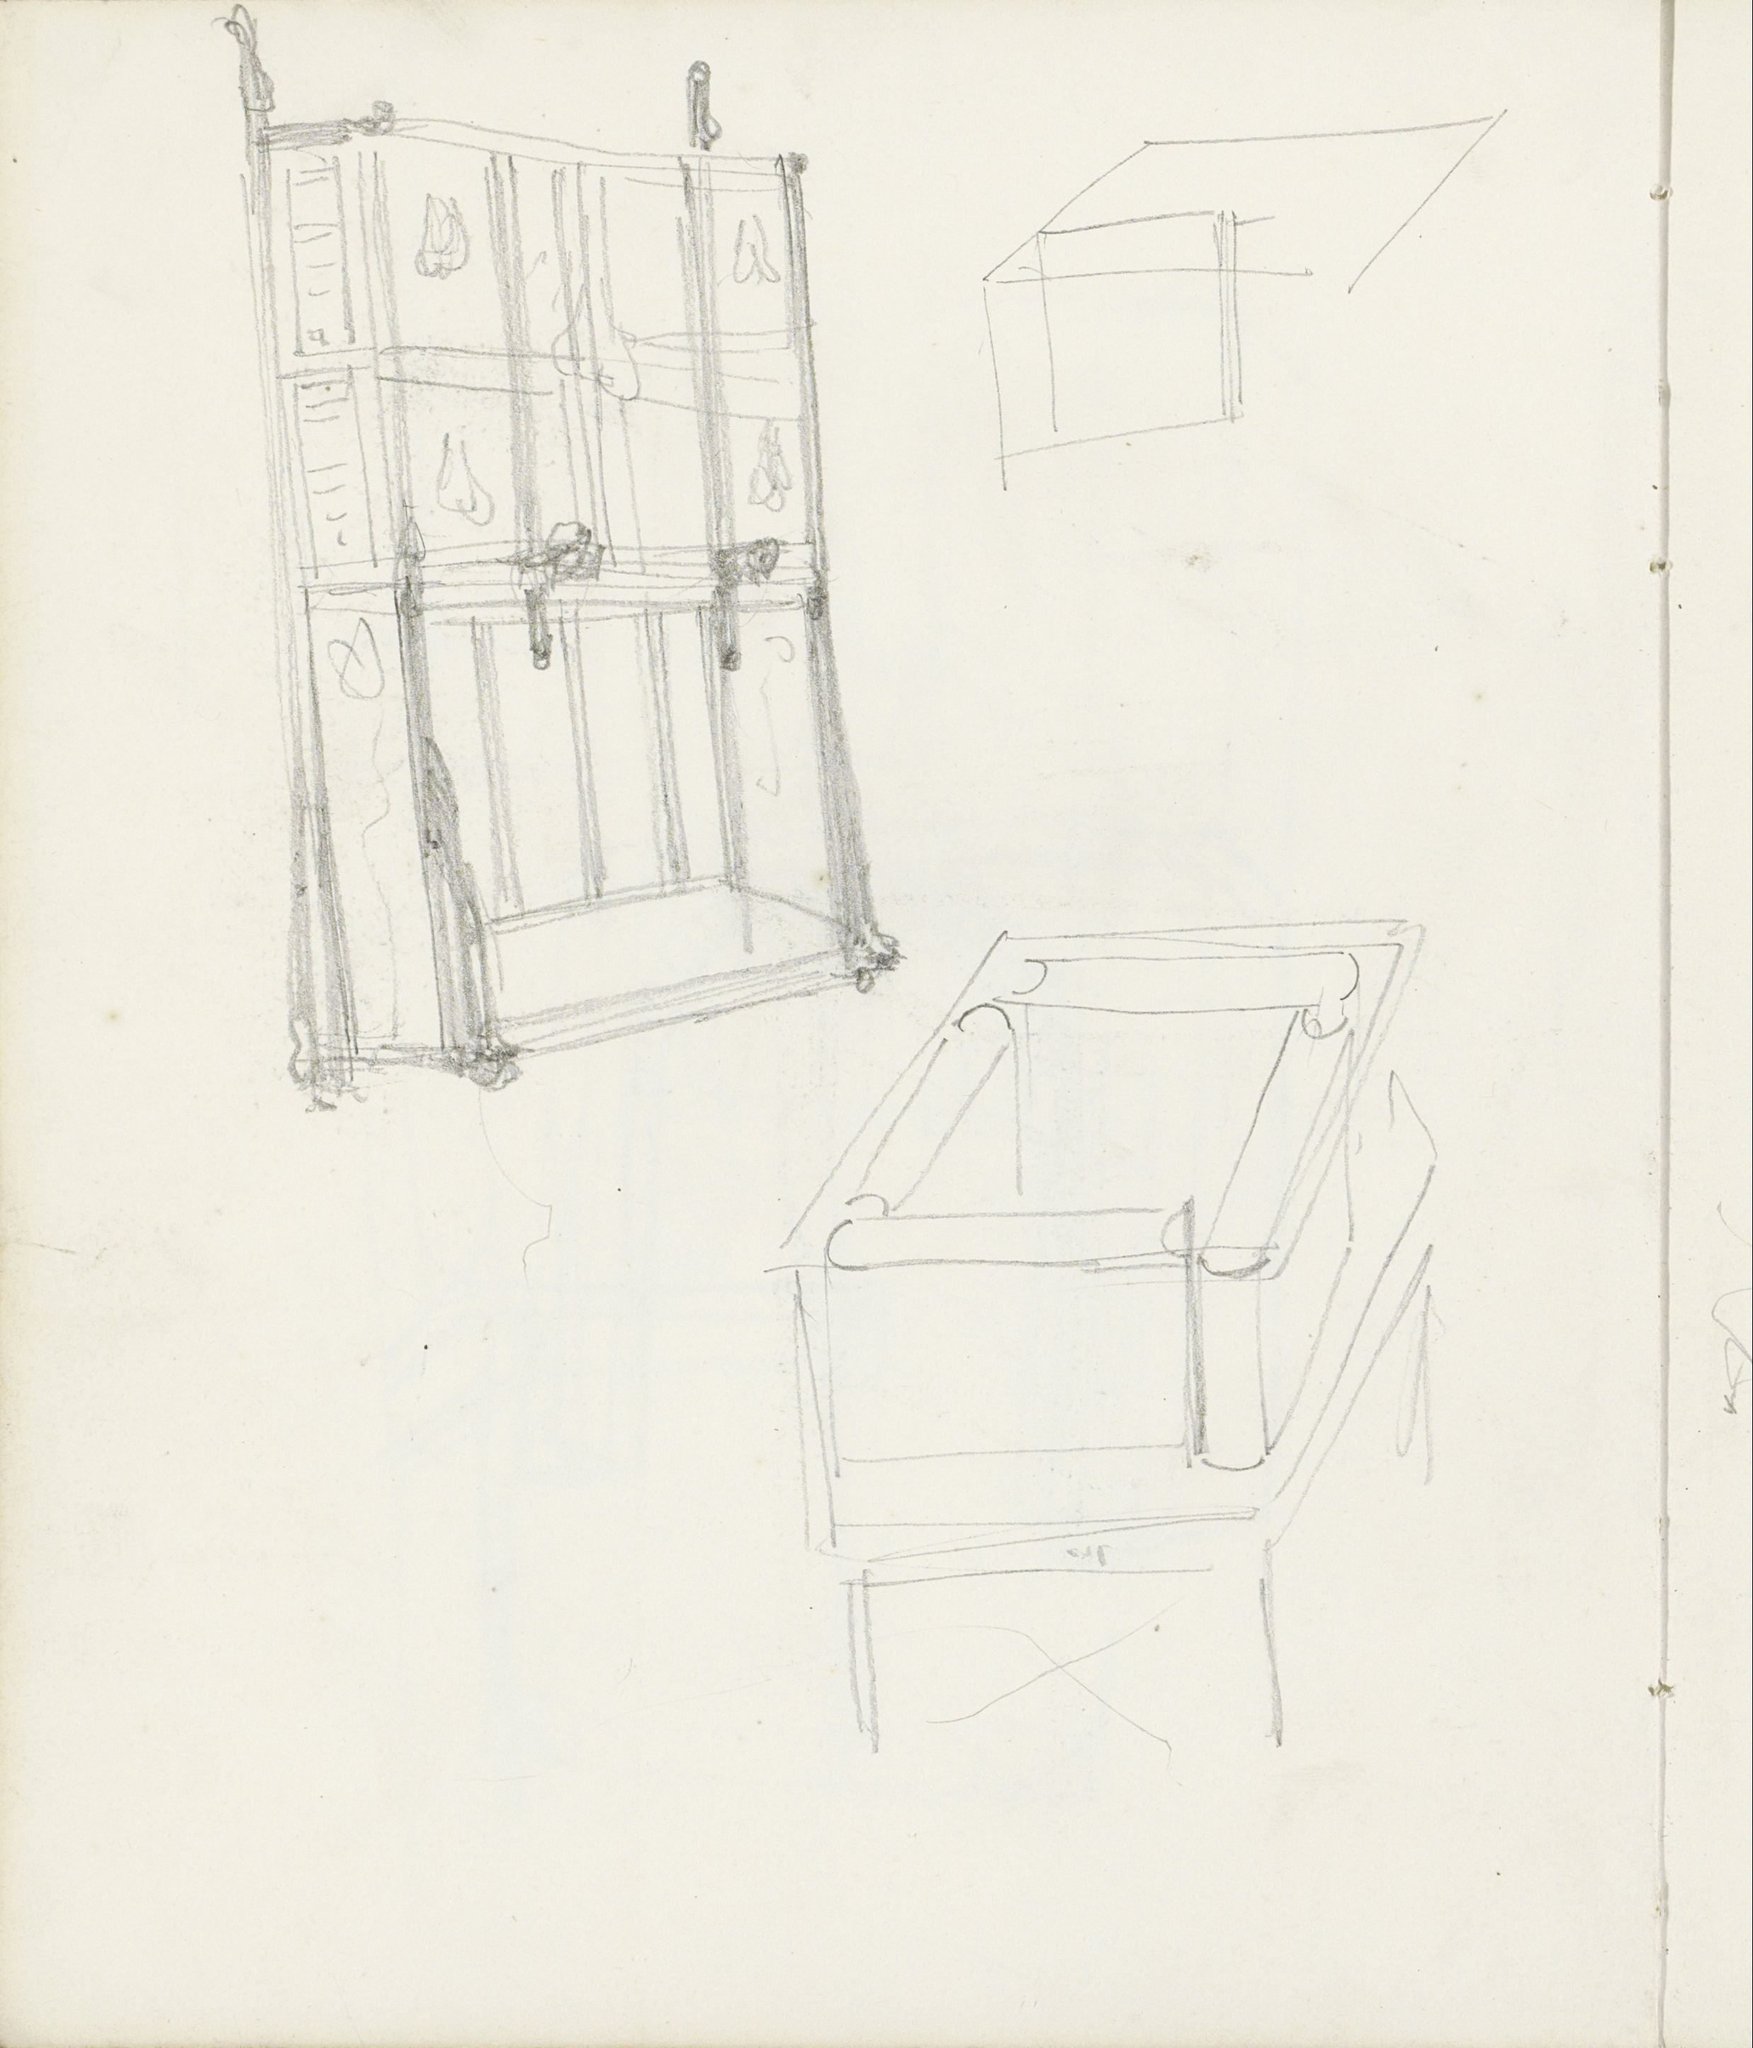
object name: sketchbook leaf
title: Ontwerpen voor kasten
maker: carel adolph lion cachet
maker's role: draughtsman, print maker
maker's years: 1864-1945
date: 1900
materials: paper, pencil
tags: furniture for storage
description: Blad 5 verso uit een schetsboek met 15 bladen.